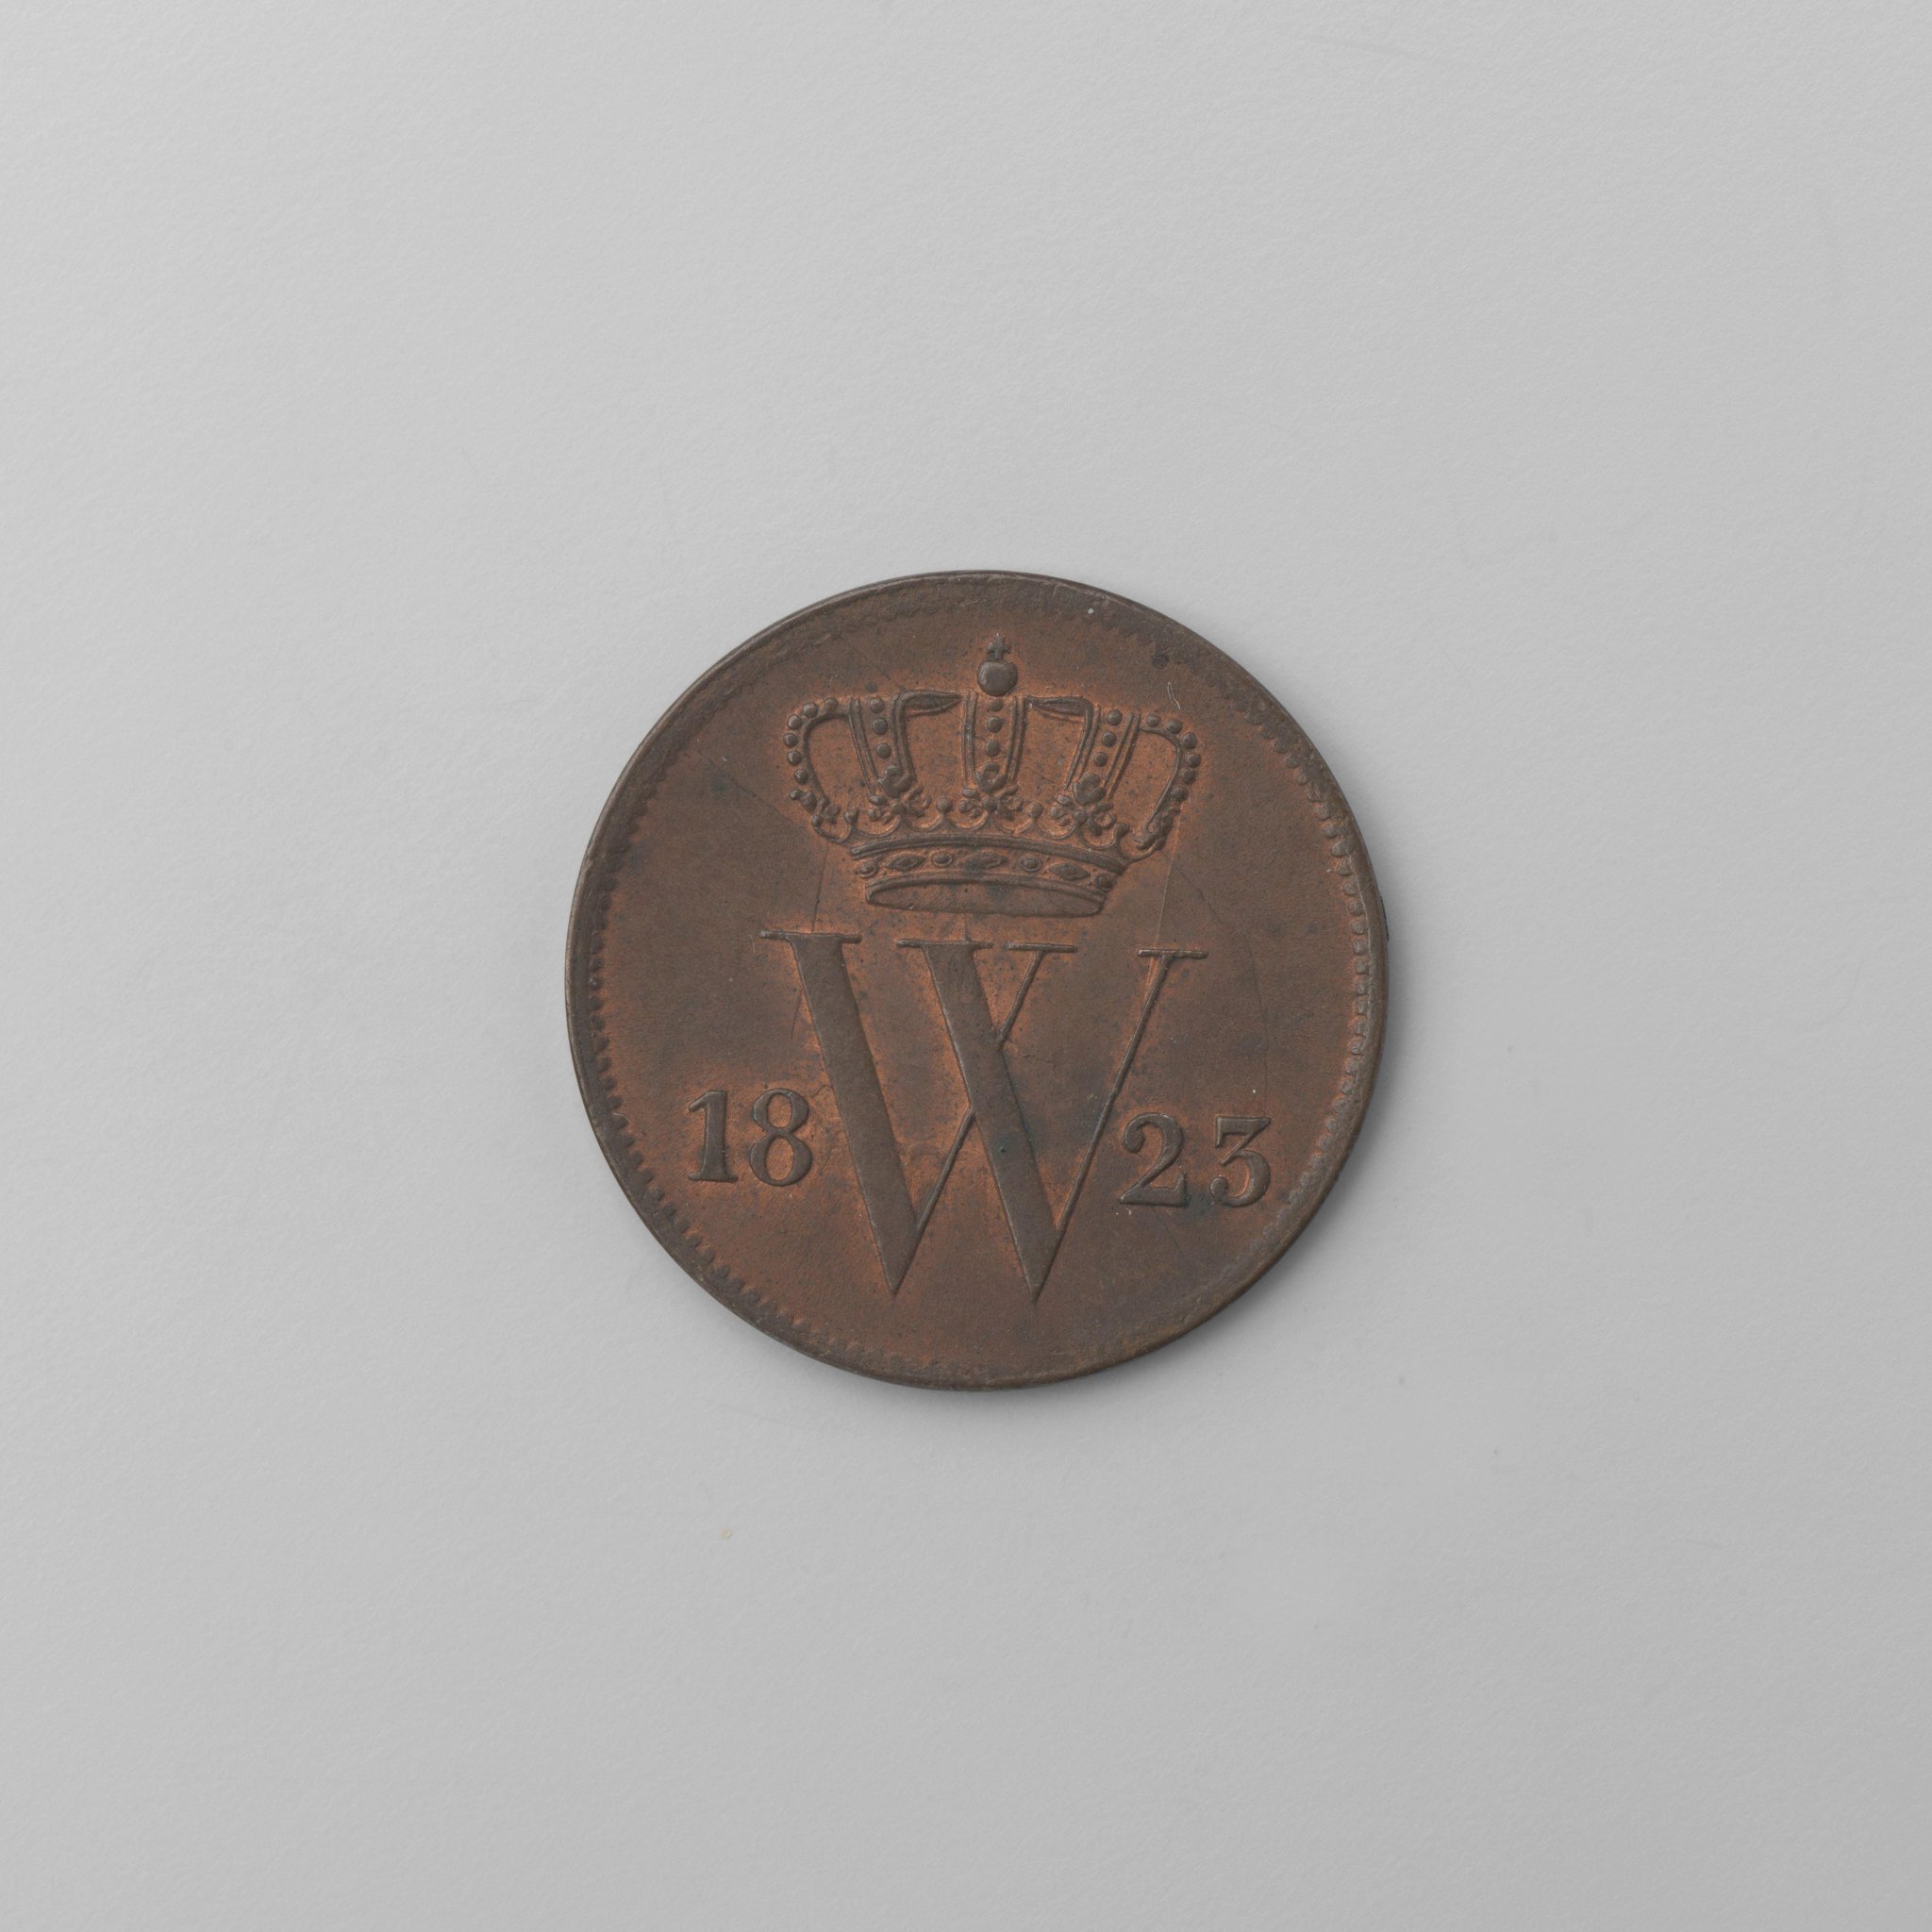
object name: coin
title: Nederland, cent, 1823 Utrecht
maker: william i of the netherlands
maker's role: koning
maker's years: 1772-1843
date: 1823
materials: copper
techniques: striking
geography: utrecht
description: Koperen munt. Voorzijde: tussen jaartal gekroonde rechte letter W. Keerzijde: tussen waarde-aanduiding 1 C. gekroond rijkswapenschild. Gladde rand.